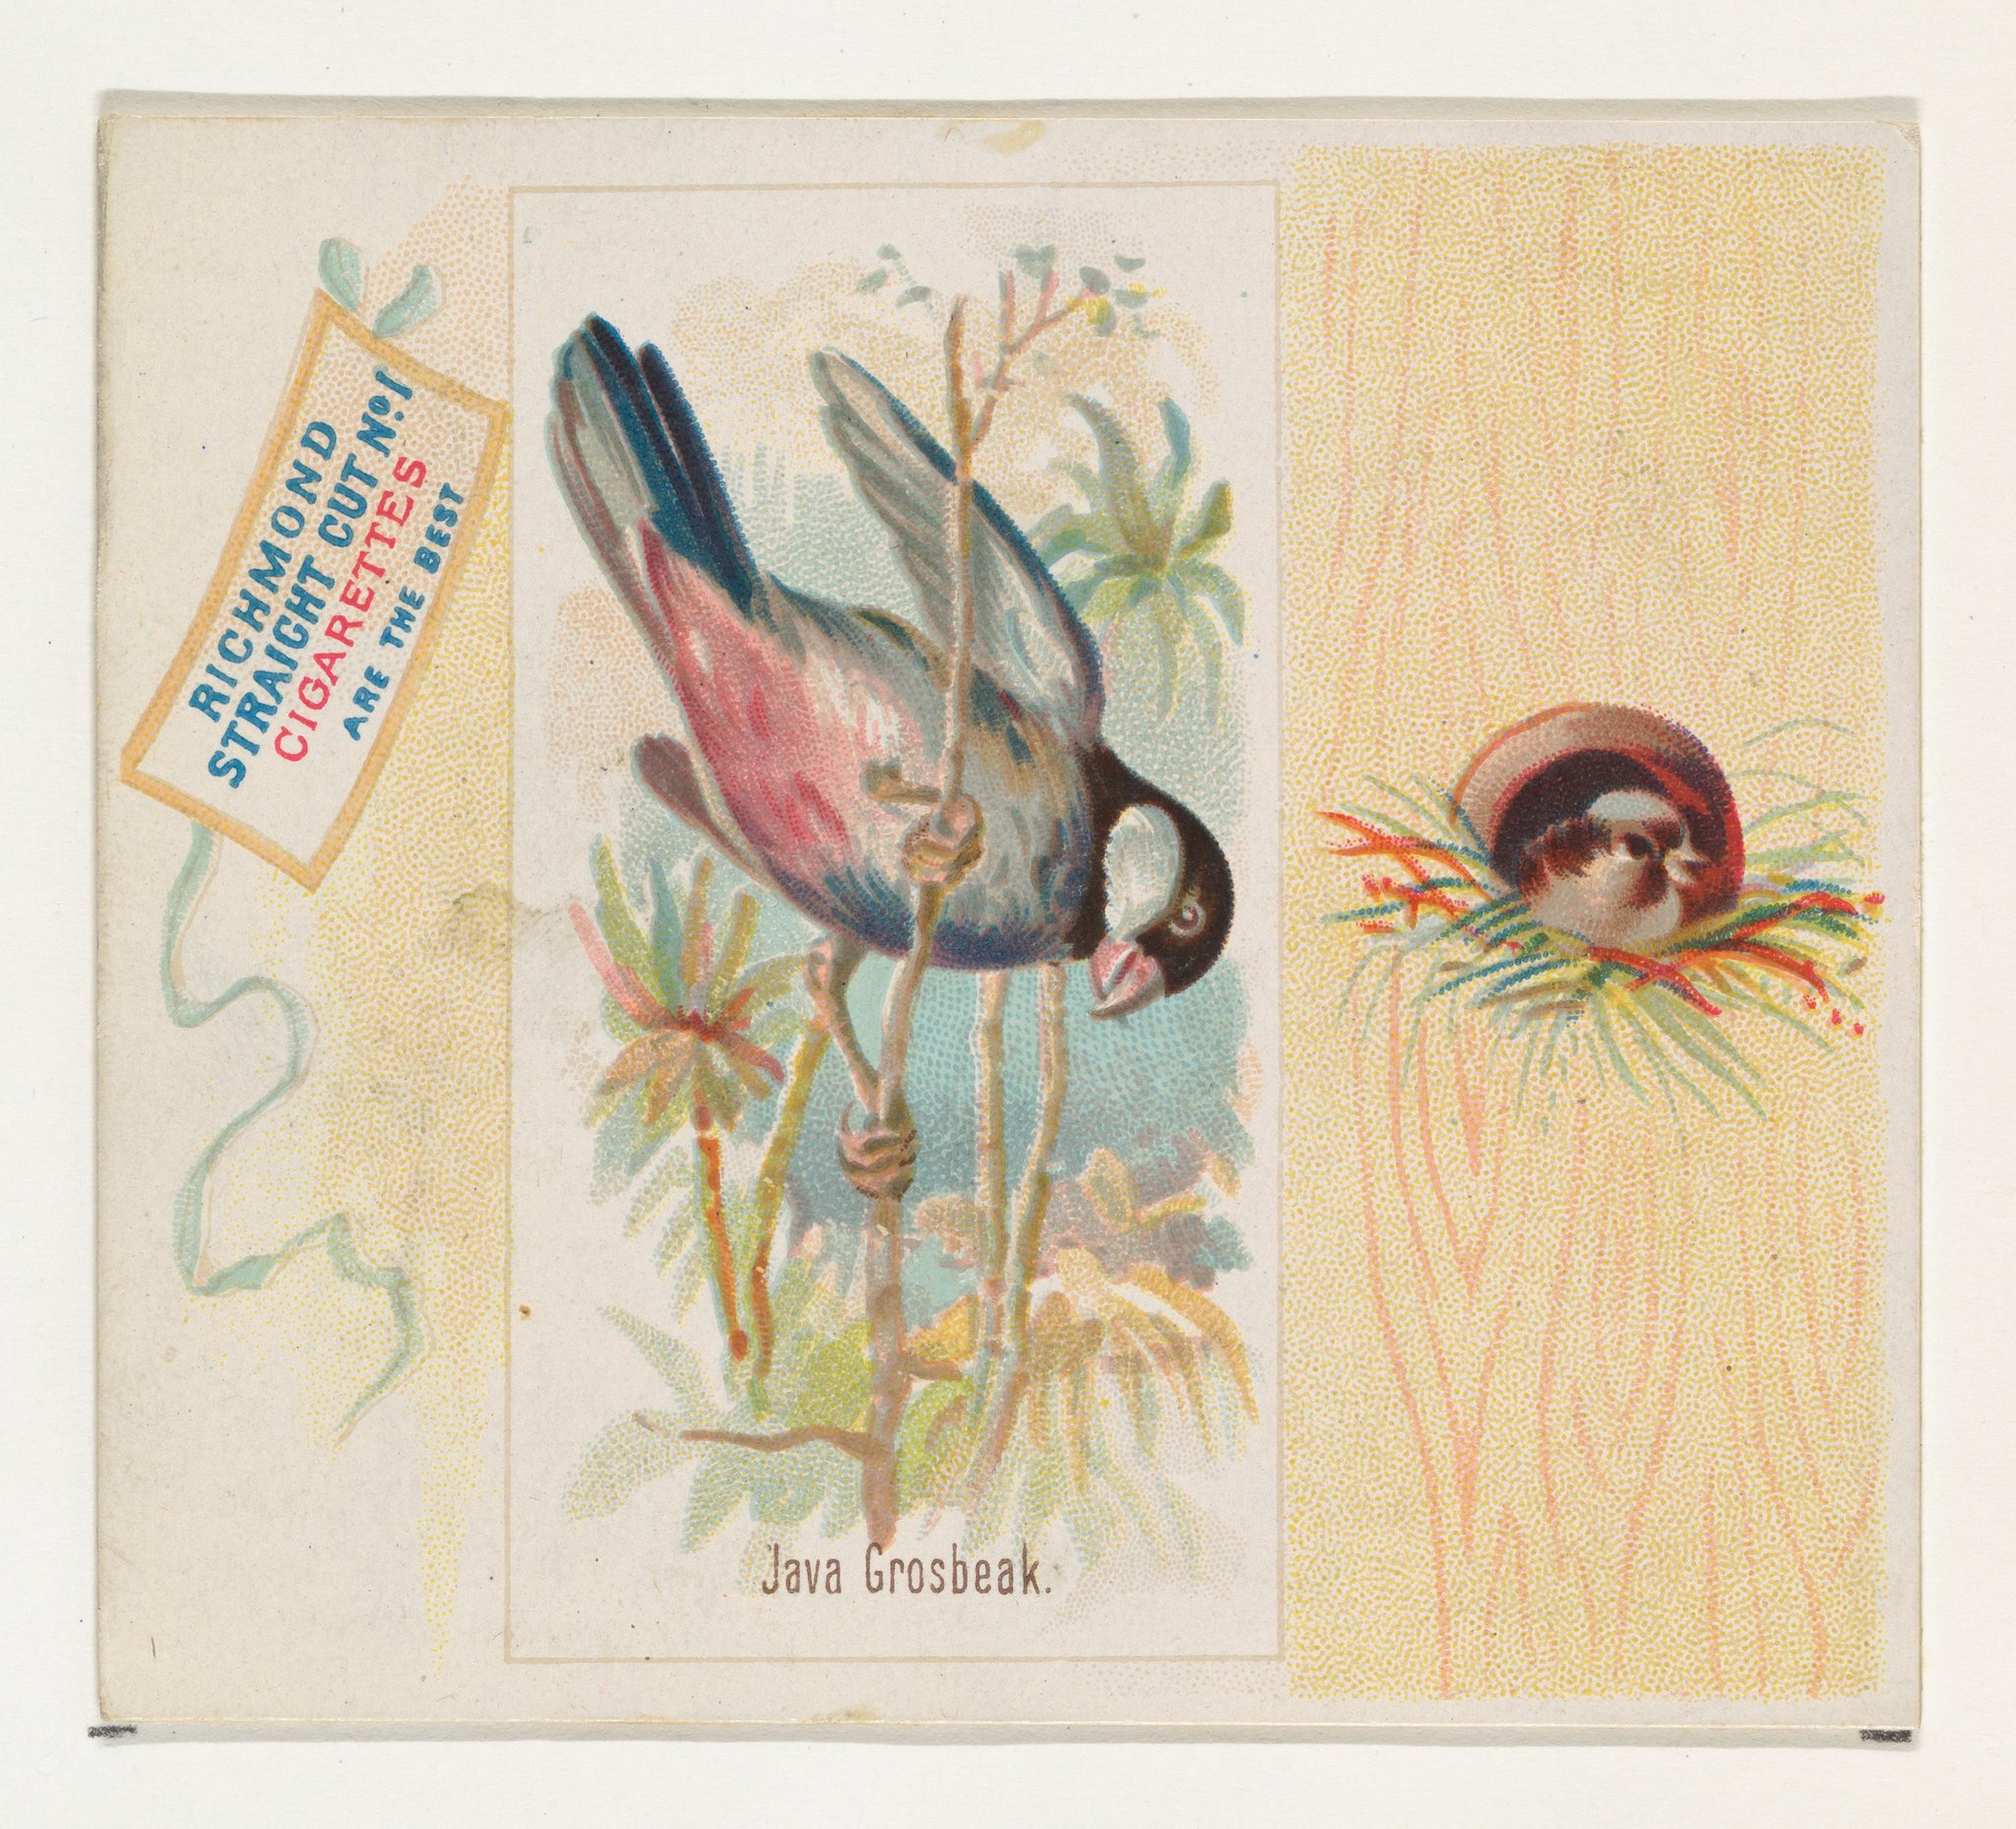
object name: print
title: Java Grosbeak, from the Song Birds of the World series (N42) for Allen & Ginter Cigarettes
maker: allen & ginter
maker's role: publisher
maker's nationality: american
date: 1890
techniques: color lithograph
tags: birds